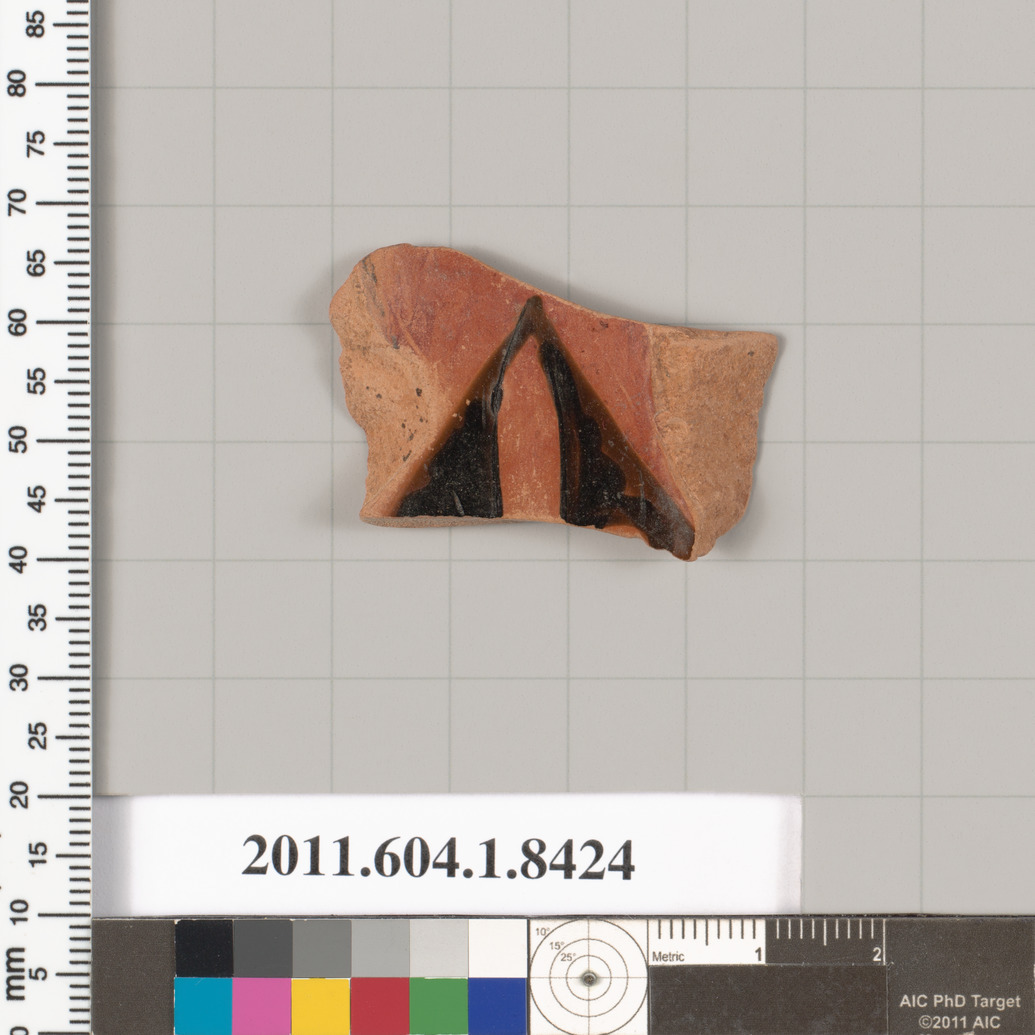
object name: kylix fragment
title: Terracotta fragment of a kylix (drinking cup)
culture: greek, attic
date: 467-435 BCE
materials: terracotta